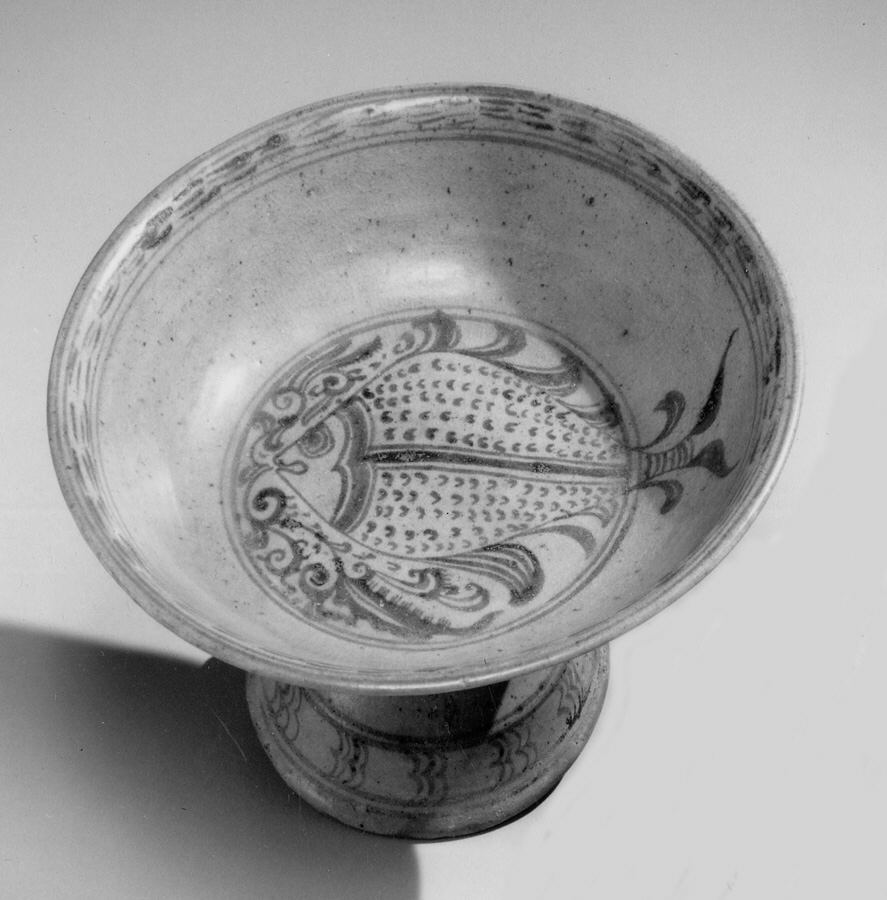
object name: stem dish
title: Stem Dish with Fish Design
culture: thai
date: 1401-1600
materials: earthenware, glaze, iron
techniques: underglaze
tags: fish